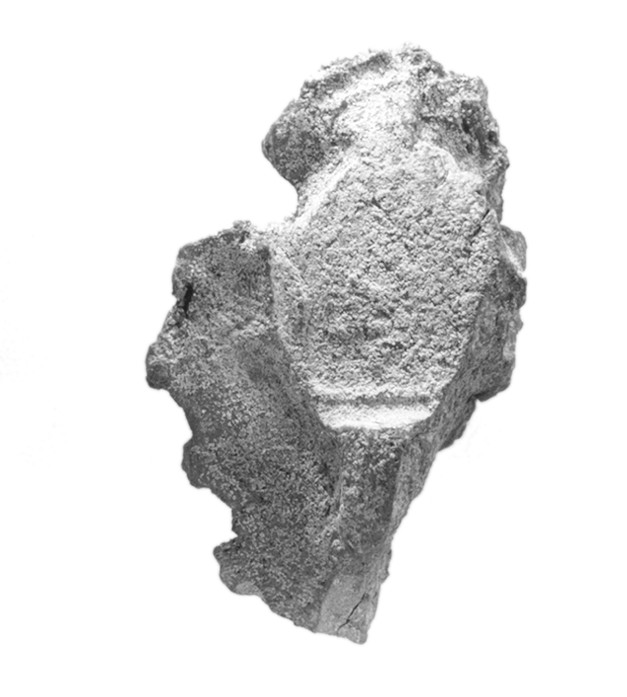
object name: sealing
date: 2030-1640 BCE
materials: clay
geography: egypt